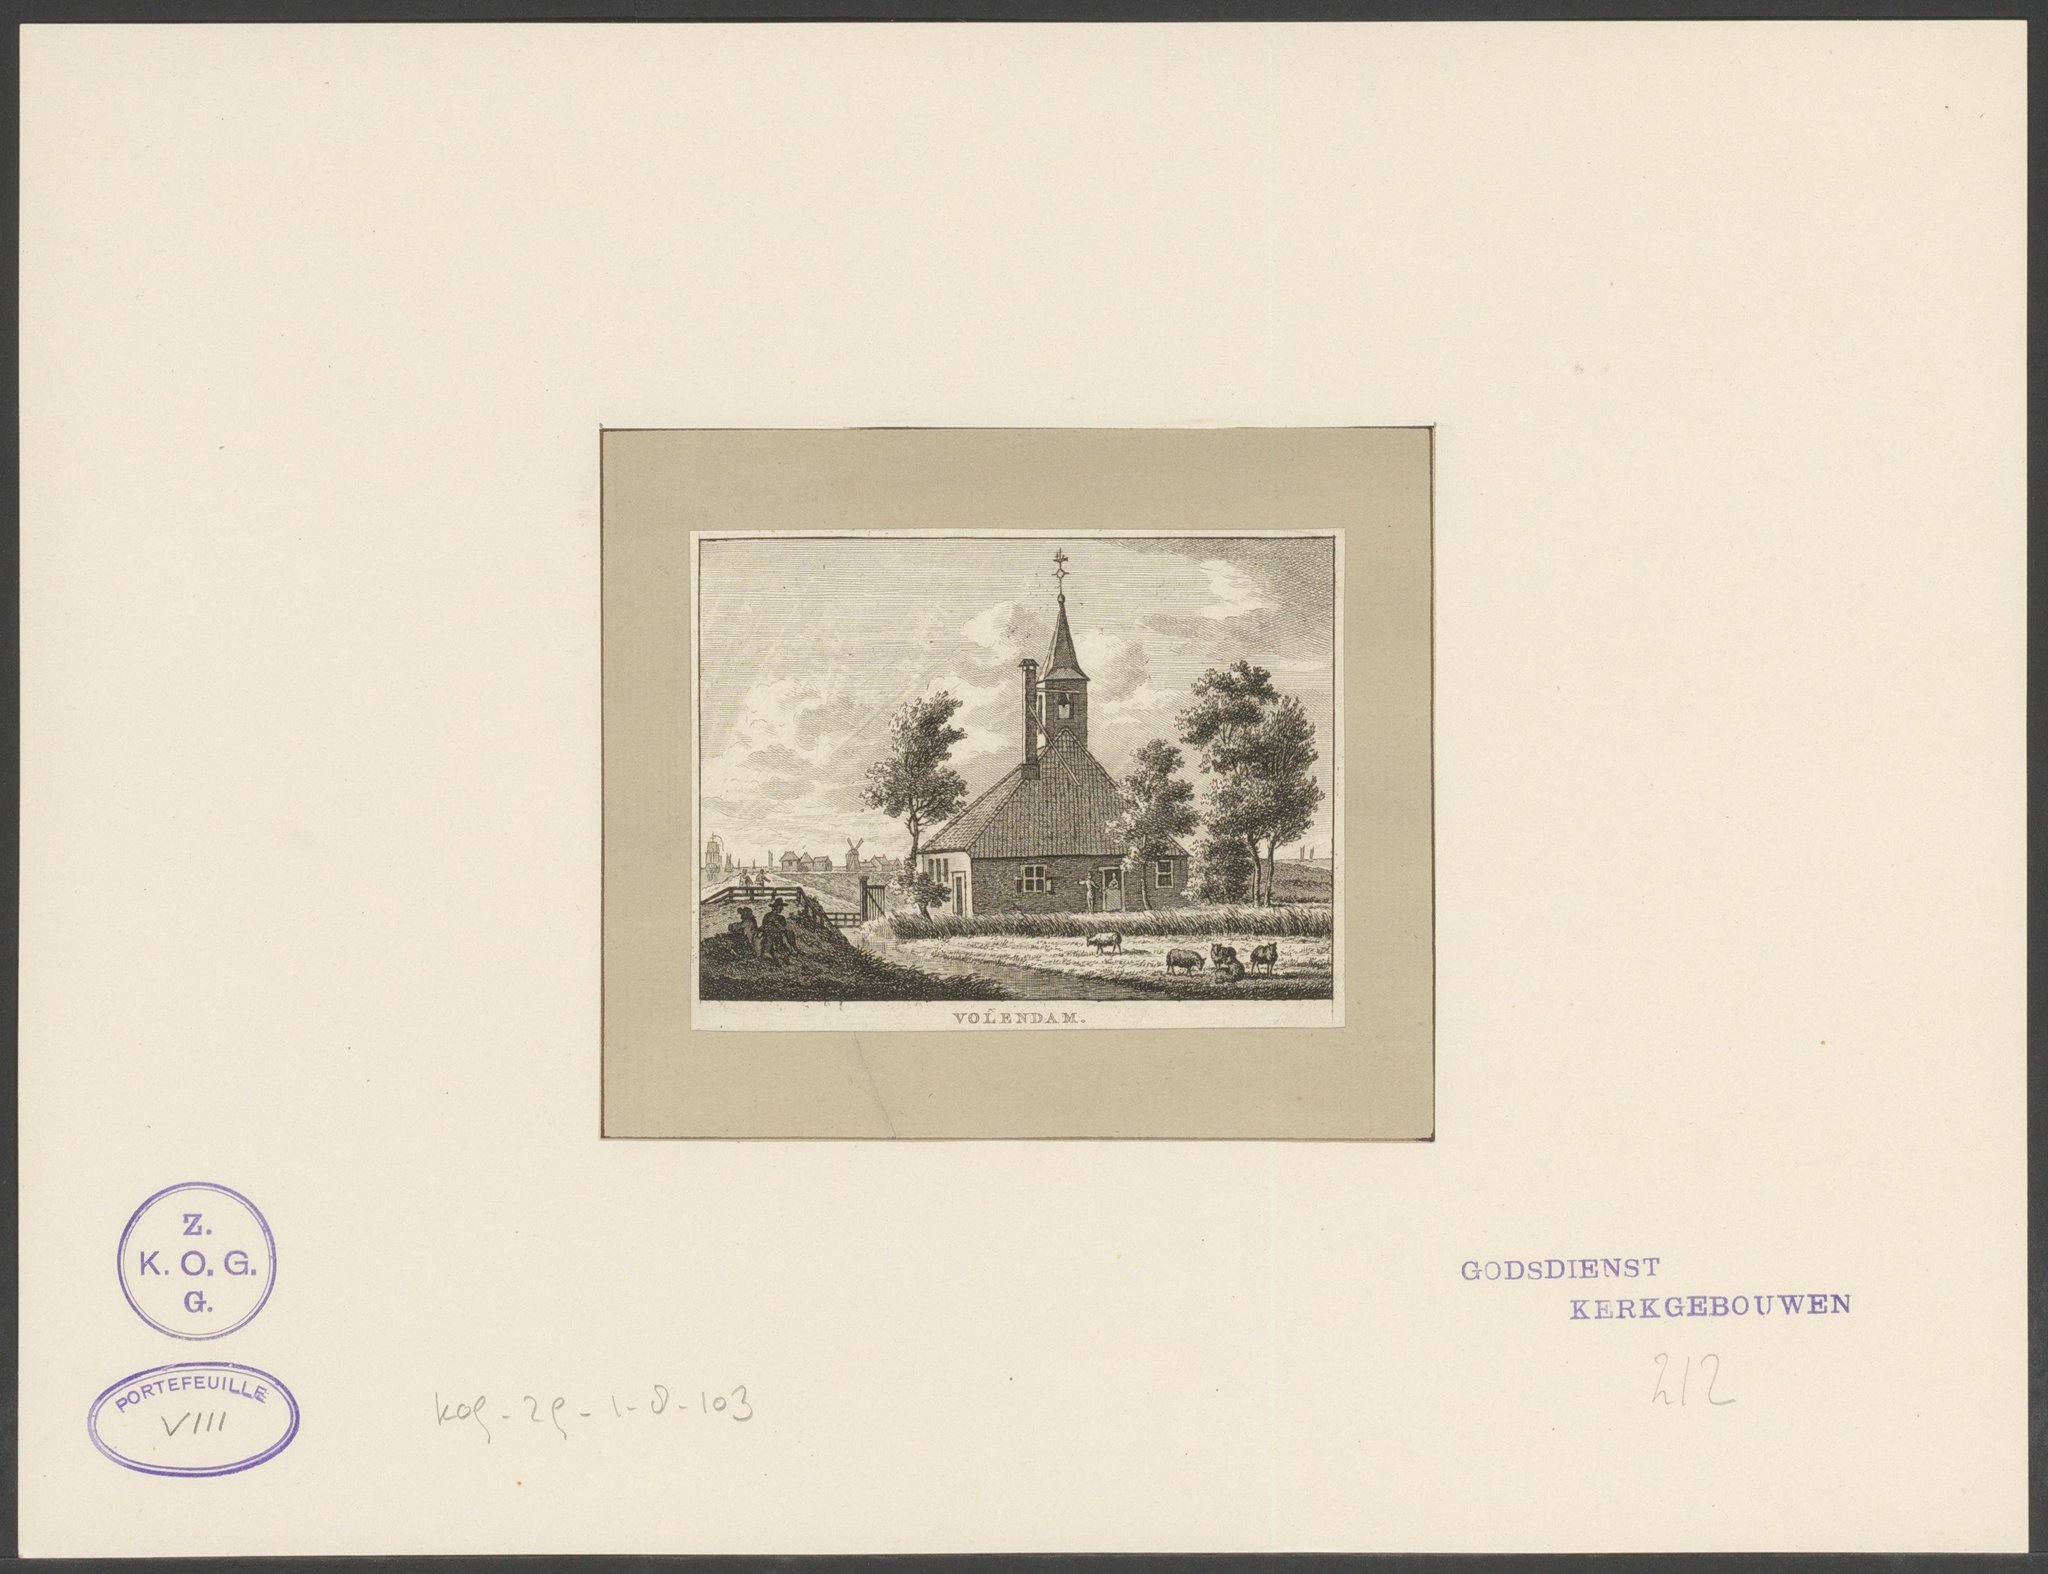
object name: book illustration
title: Gezicht op de Stolpkerk te Volendam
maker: carel frederik bendorp (i)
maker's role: print maker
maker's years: 1736-1814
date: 1786-1792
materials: paper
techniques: etching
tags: church (exterior)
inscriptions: collector's mark, collector's mark: Lugt 1641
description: Prent uit: Vaderlandsche gezichten, of afbeeldingen van den tegenwoordigen staat der Vereenigde Nederlanden (…). Amsterdam: Hendrik Gartman, Willem Vermandel en Jan Willem Smit, 1786-1792. Uitgegeven in afleveringen met ieder een eigen bifolium en inhoudsopgave. Alle prenten in deze publicatie zijn gegraveerd door Carel Frederik Bendorp (I) en, in de meeste gevallen, gebaseerd op tekeningen van Jan Bulthuis